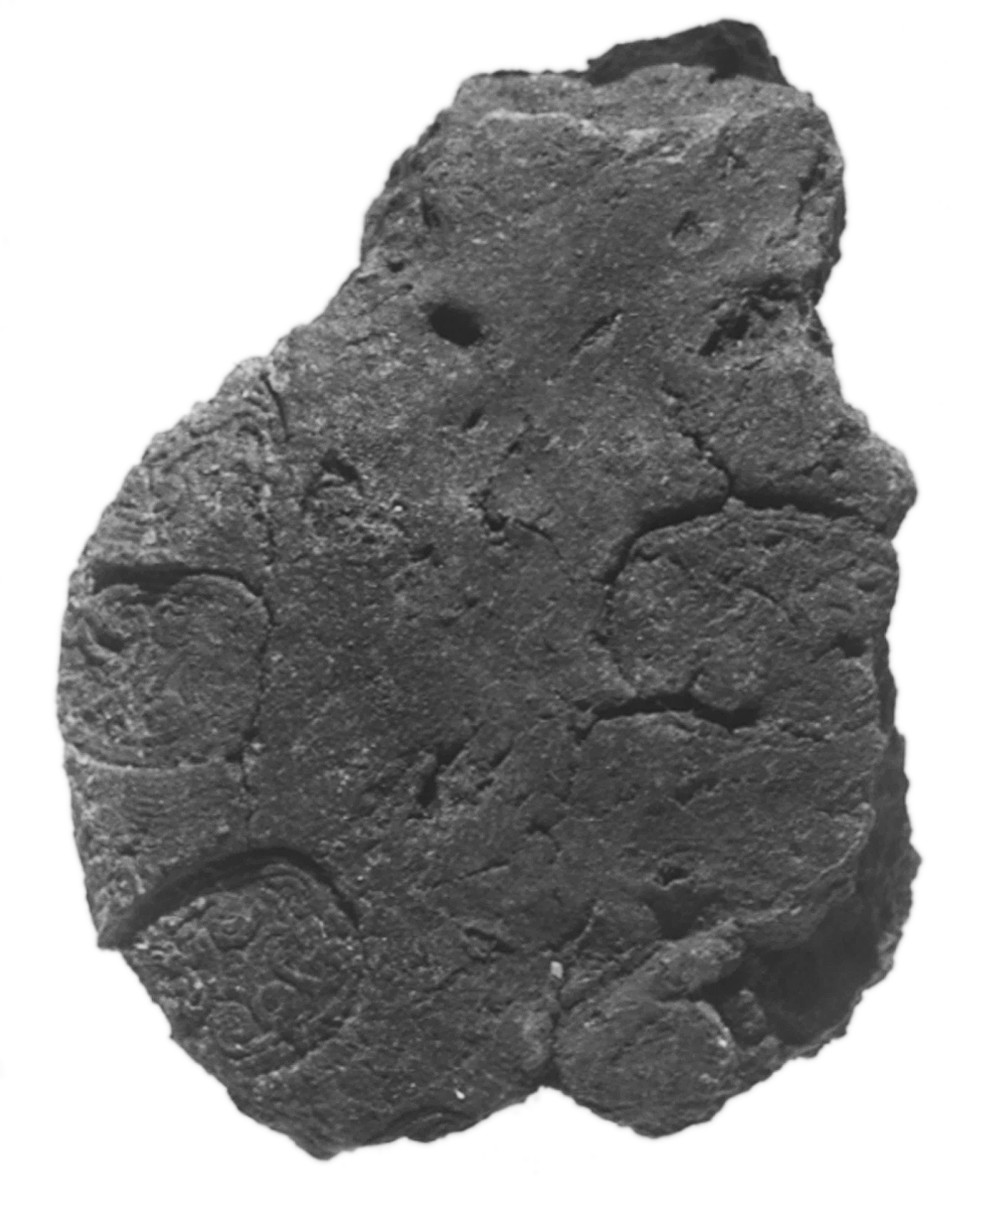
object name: sealing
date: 2030-1640 BCE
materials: clay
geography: egypt